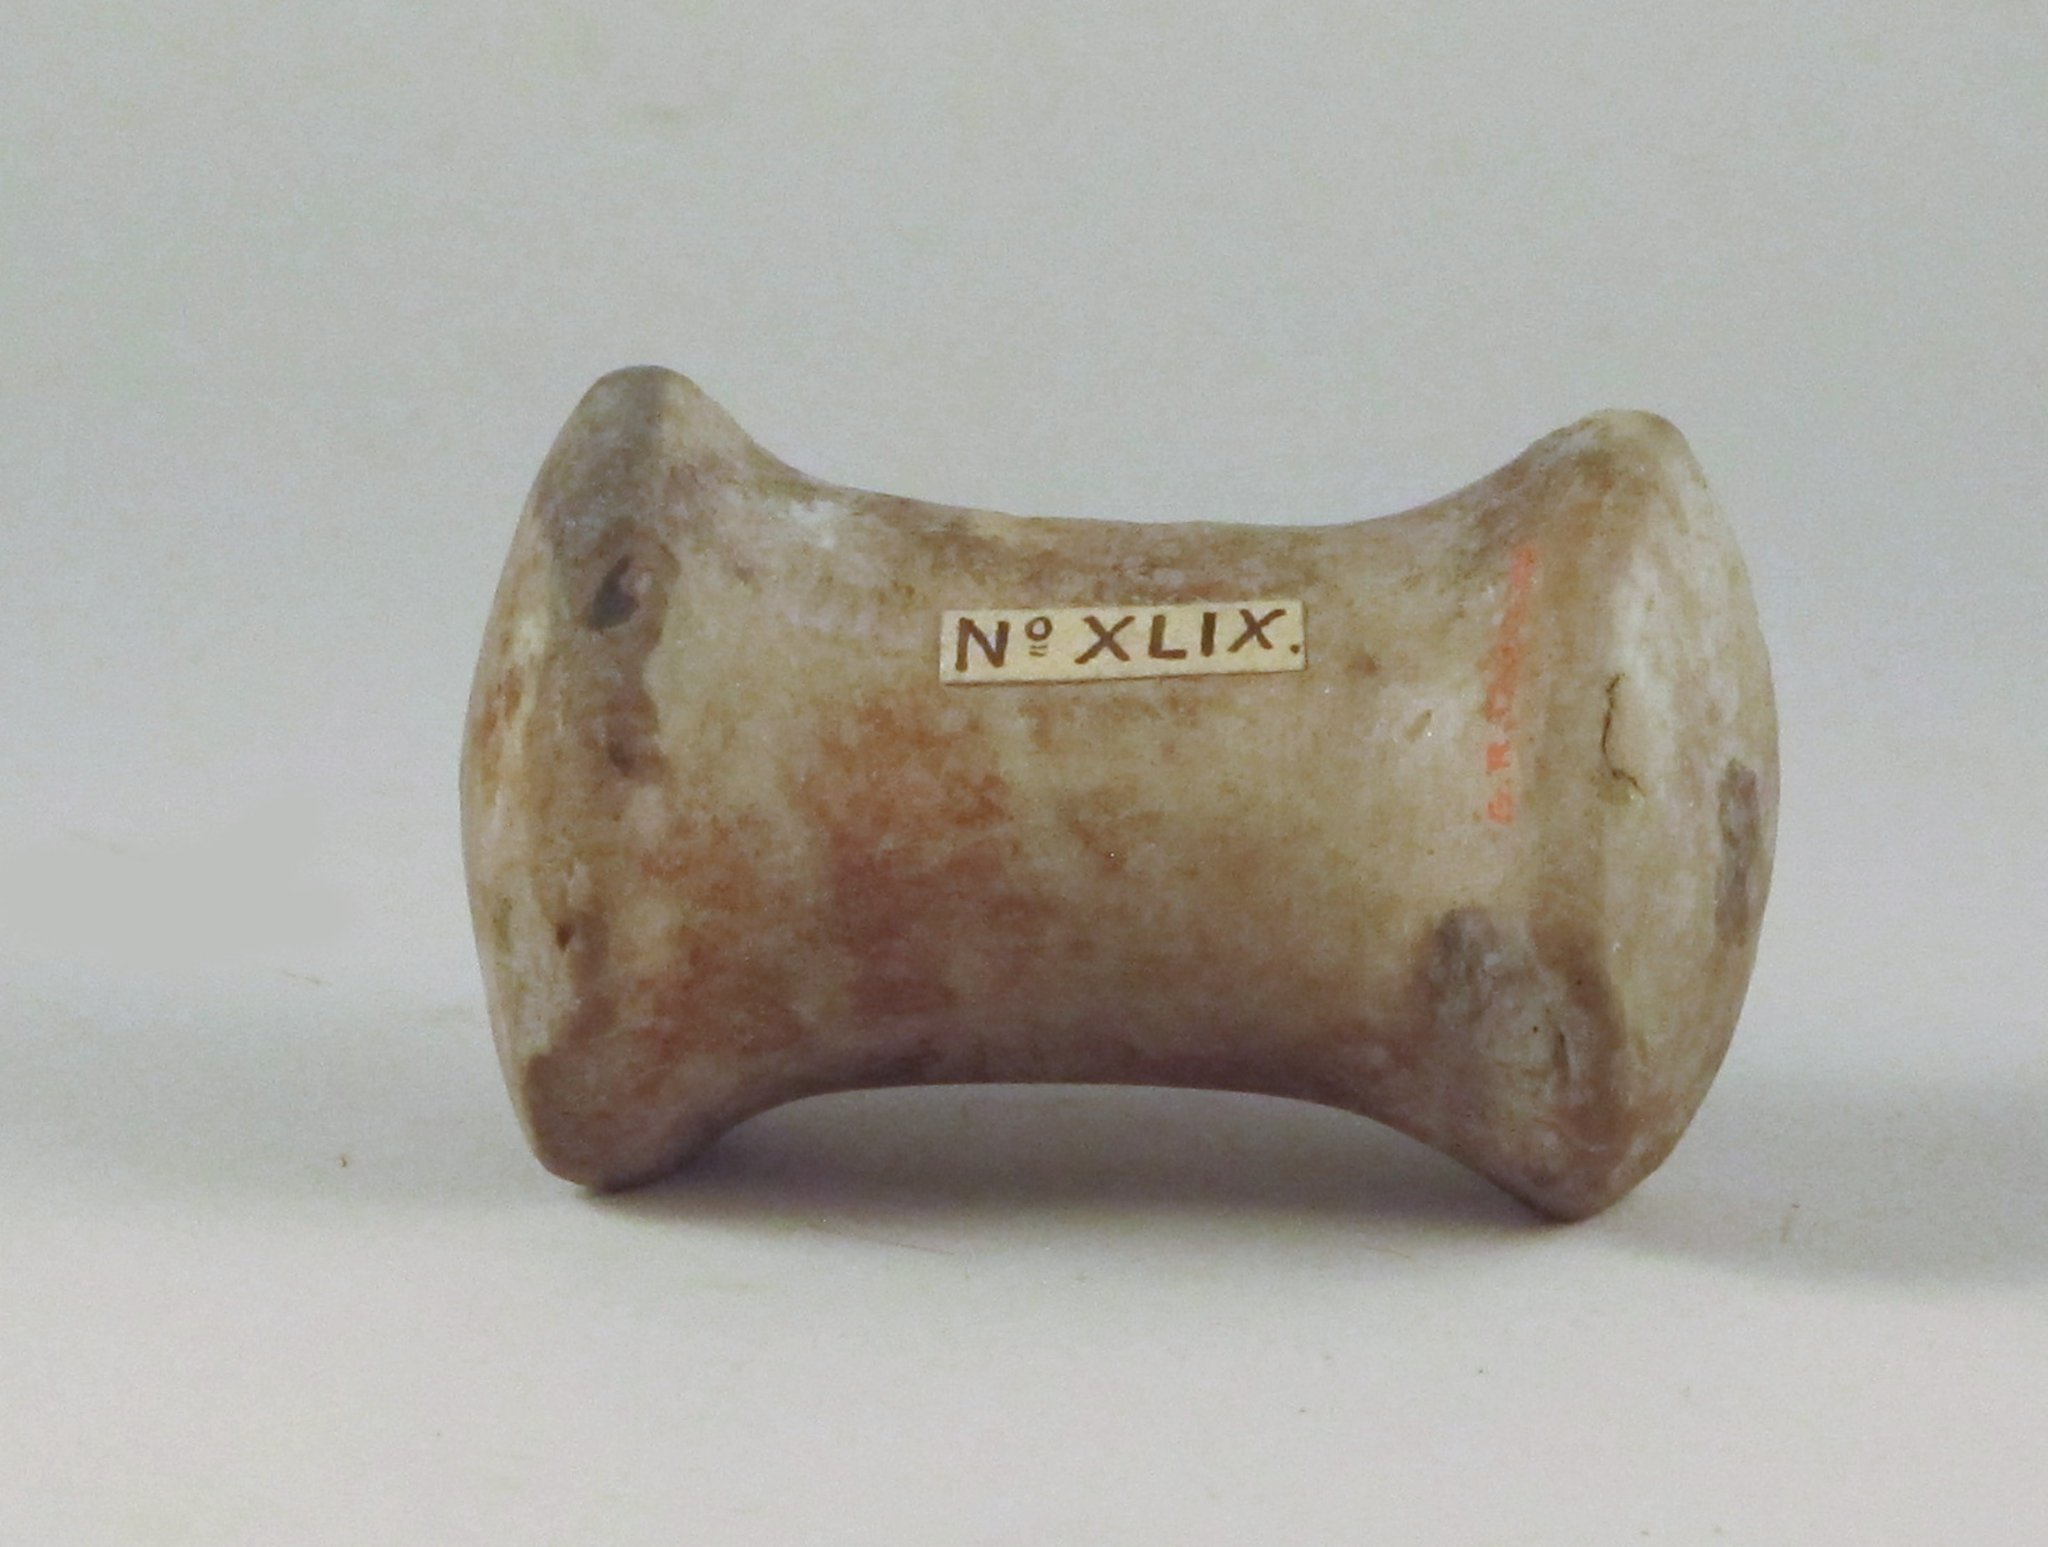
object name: spindle whorl, reel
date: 7000 BCE-330 CE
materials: clay